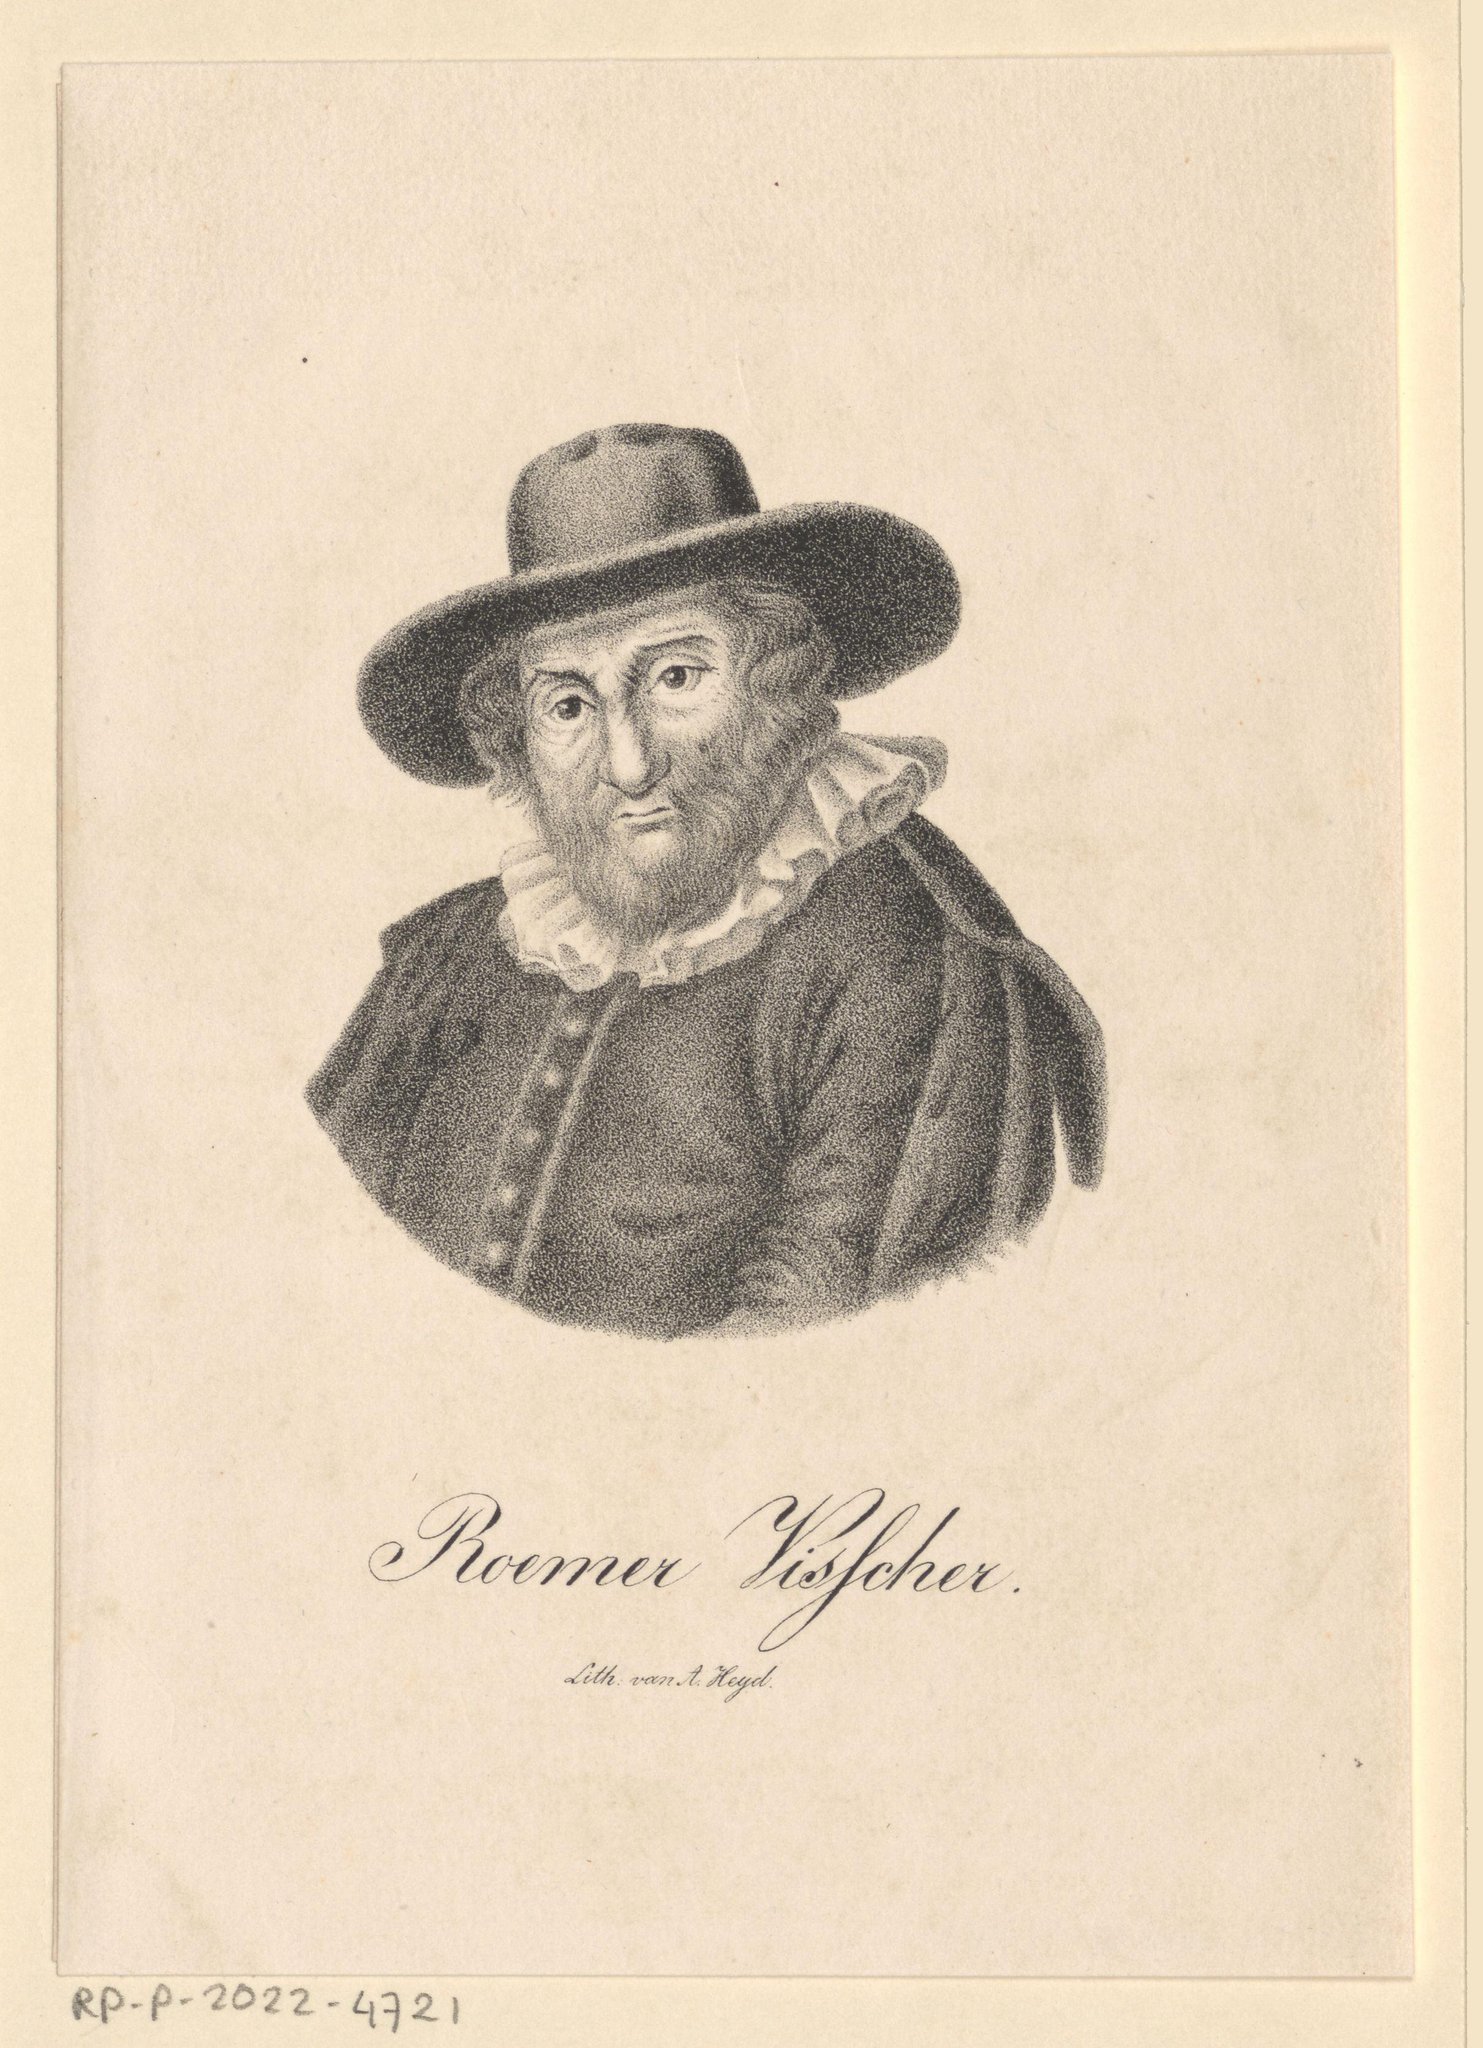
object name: print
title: Portret van Roemer Visscher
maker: a. heyd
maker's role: print maker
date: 1827-1828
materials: paper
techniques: lithograph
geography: amsterdam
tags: roemer visscher, historical persons, portrait of a writer